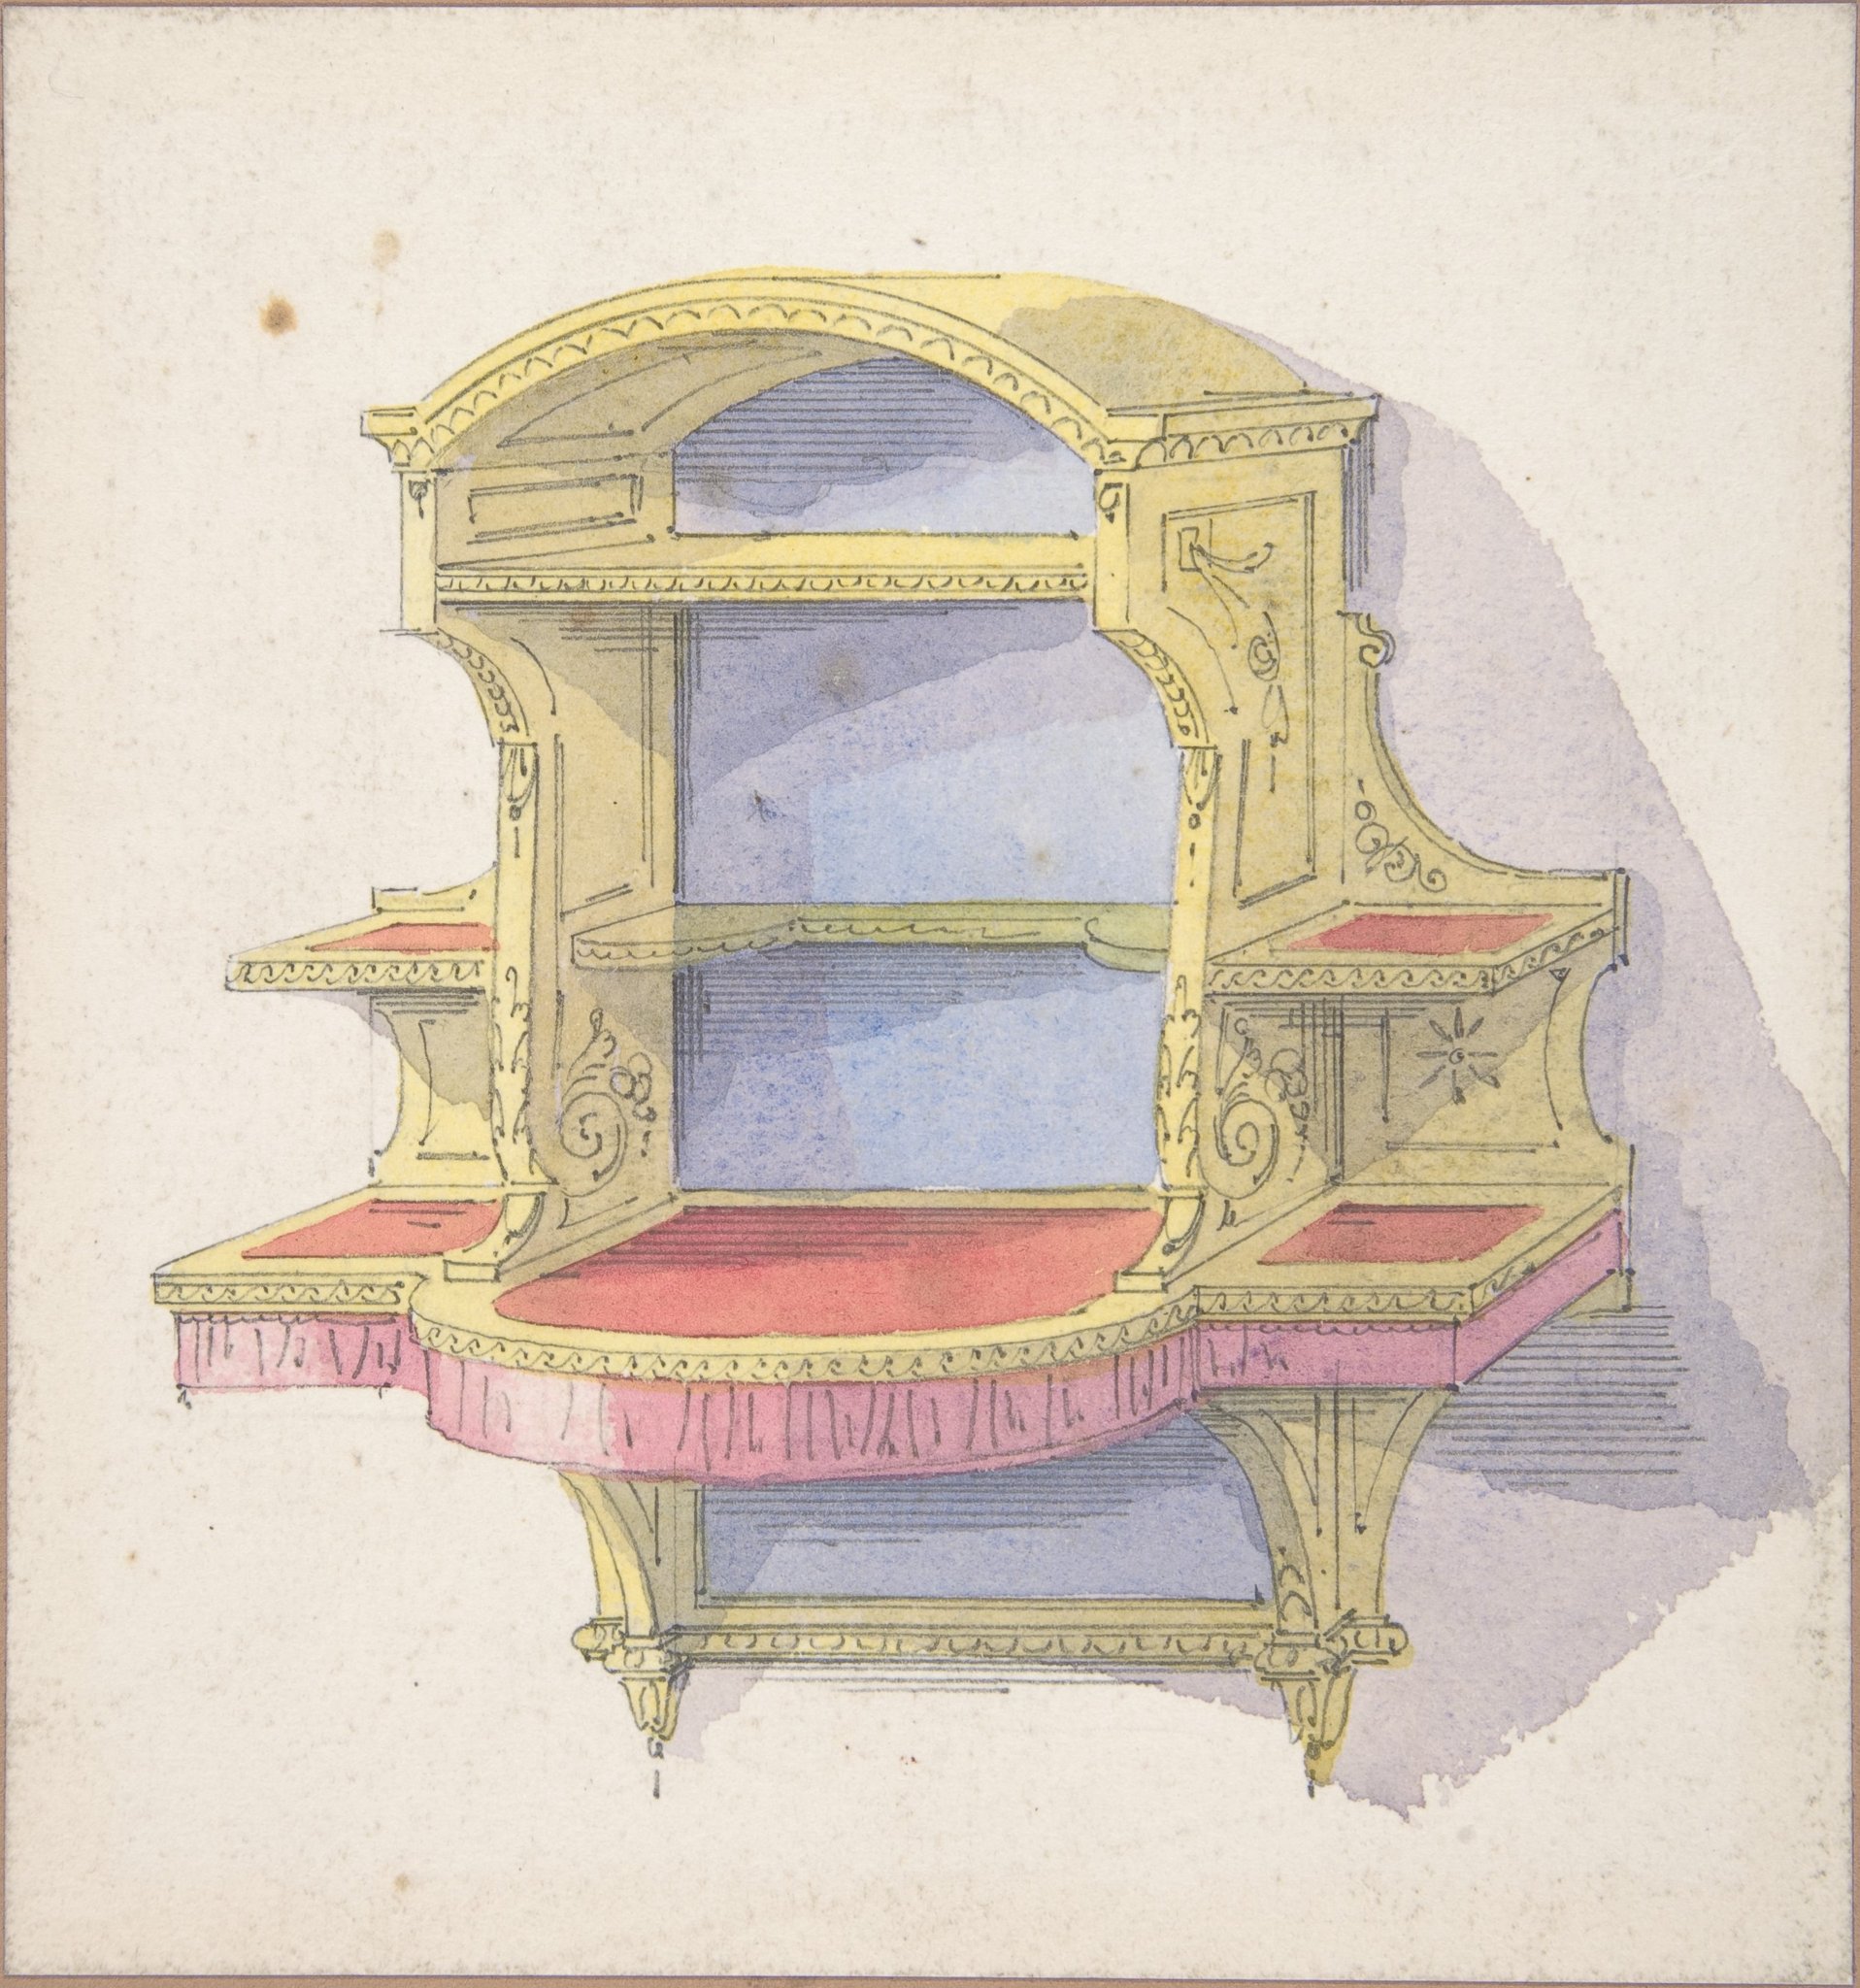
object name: drawing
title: Design for Hanging Shelves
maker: anonymous, british, 19th century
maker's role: artist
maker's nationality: british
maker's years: 1800-1900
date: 1840-1899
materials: gouache, ink, watercolor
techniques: pen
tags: furniture